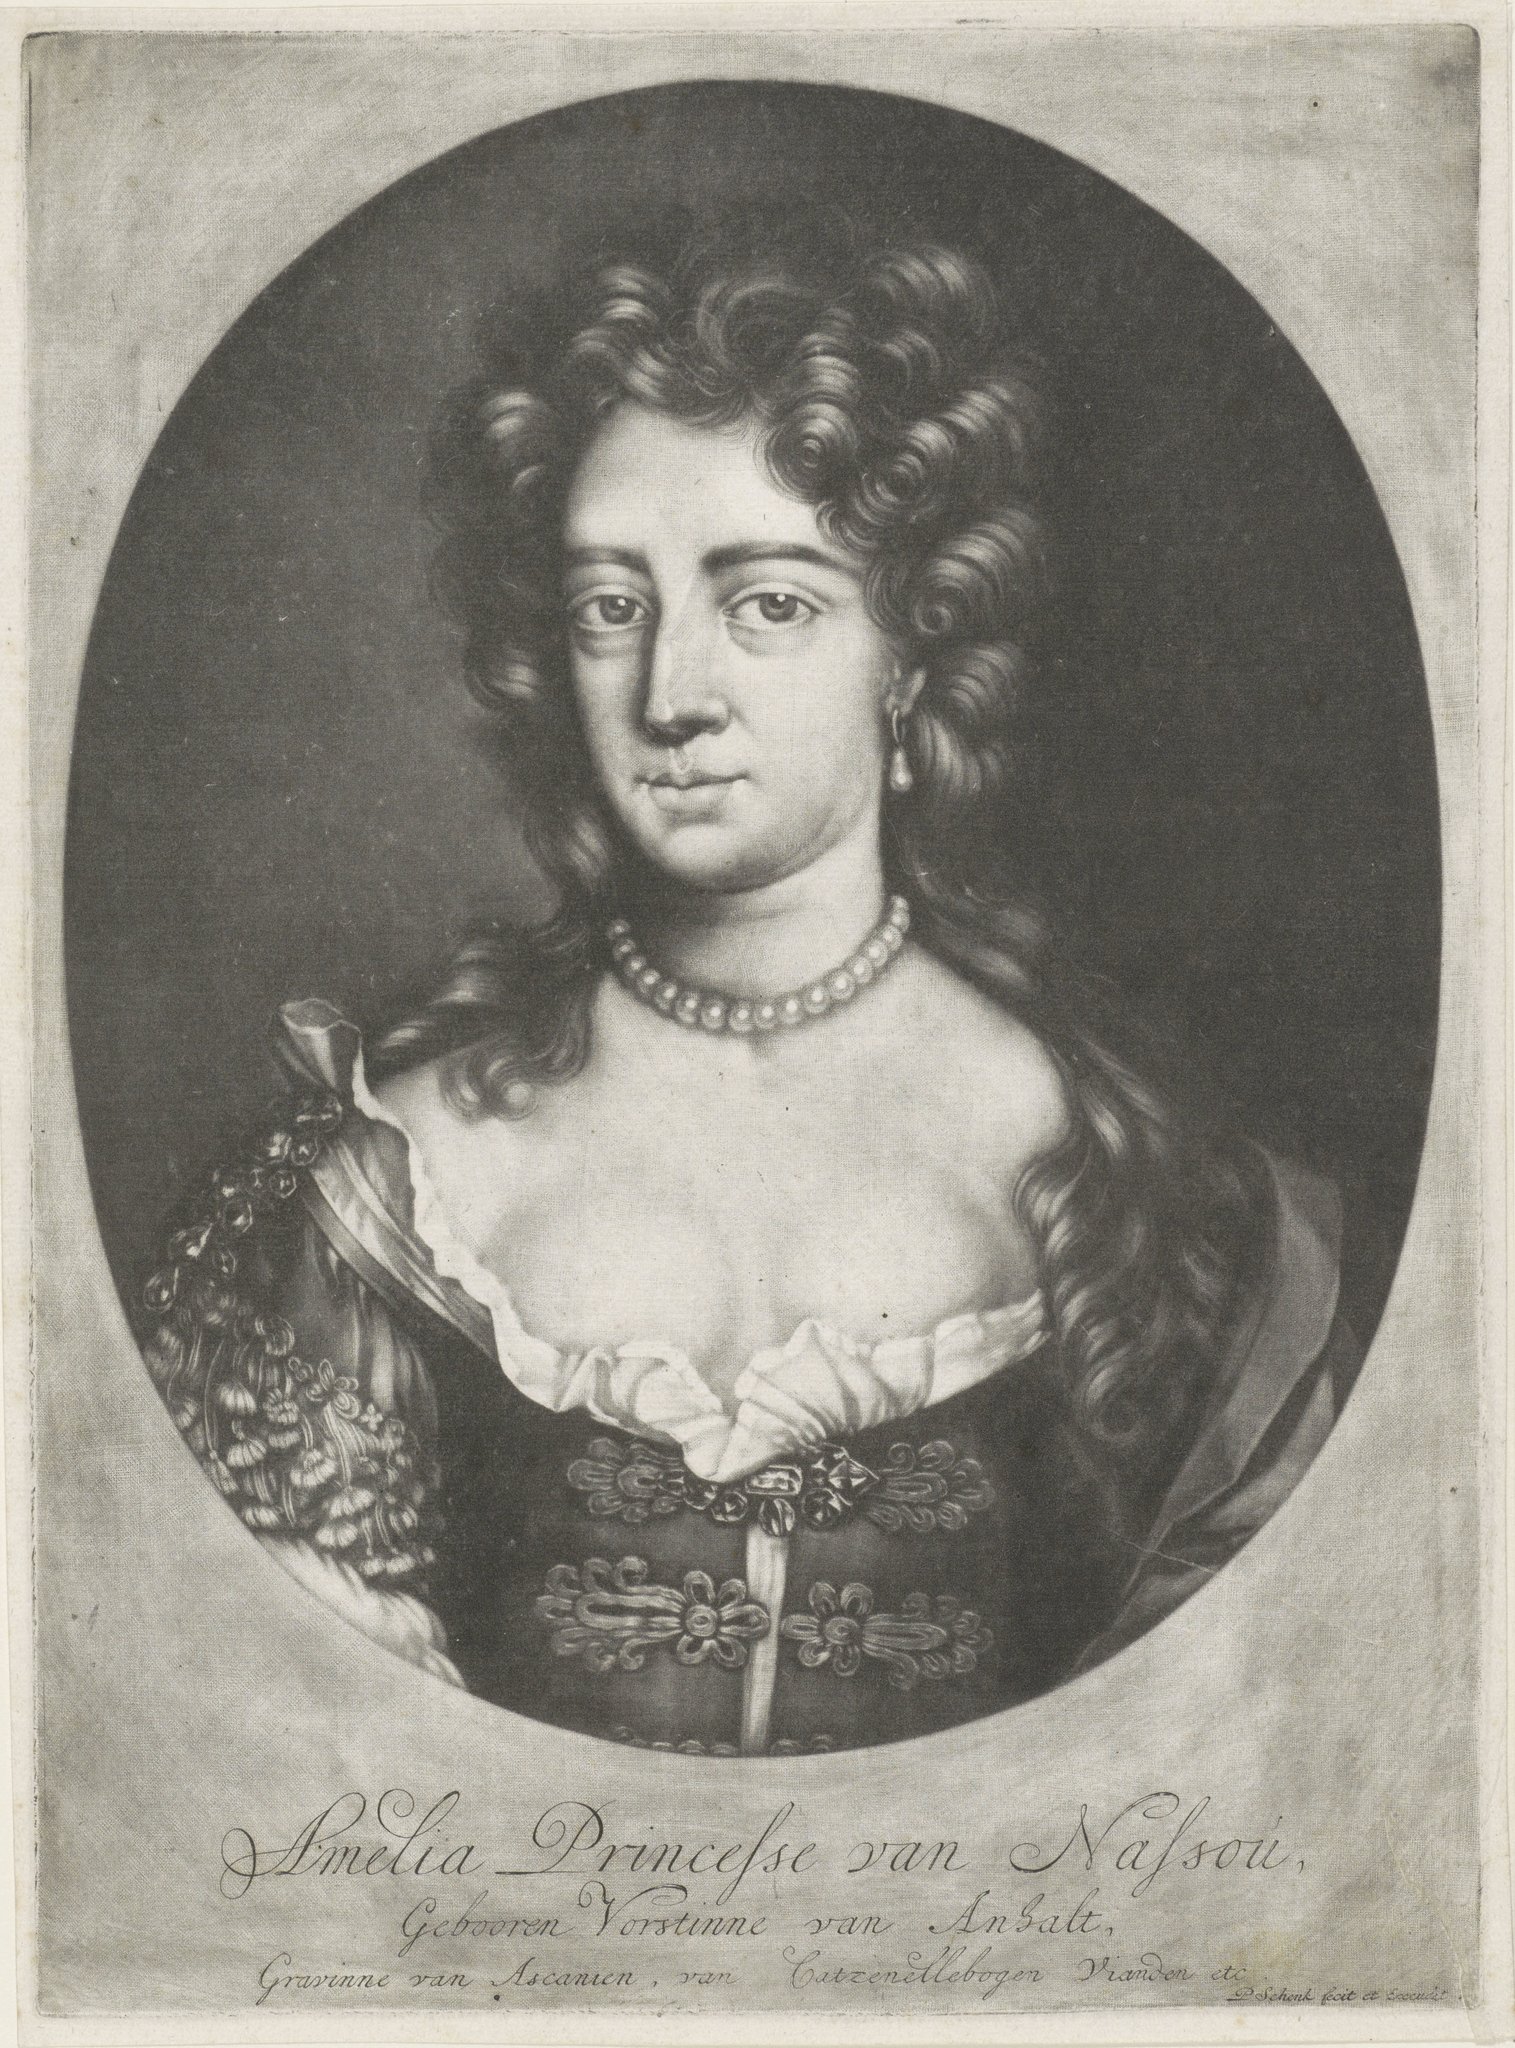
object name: print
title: Portret van Henriëtte Amalia van Anhalt-Dessau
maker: pieter schenk (i)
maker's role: print maker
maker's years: 1660-1711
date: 1683-1711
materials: paper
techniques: mezzotint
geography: amsterdam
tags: cleves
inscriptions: collector's mark: Lugt 963, collector's mark: Lugt 2165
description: Portret van Henriëtte Amalia van Anhalt-Dessau in een ovaal. In de ondermarge haar naam en titels.